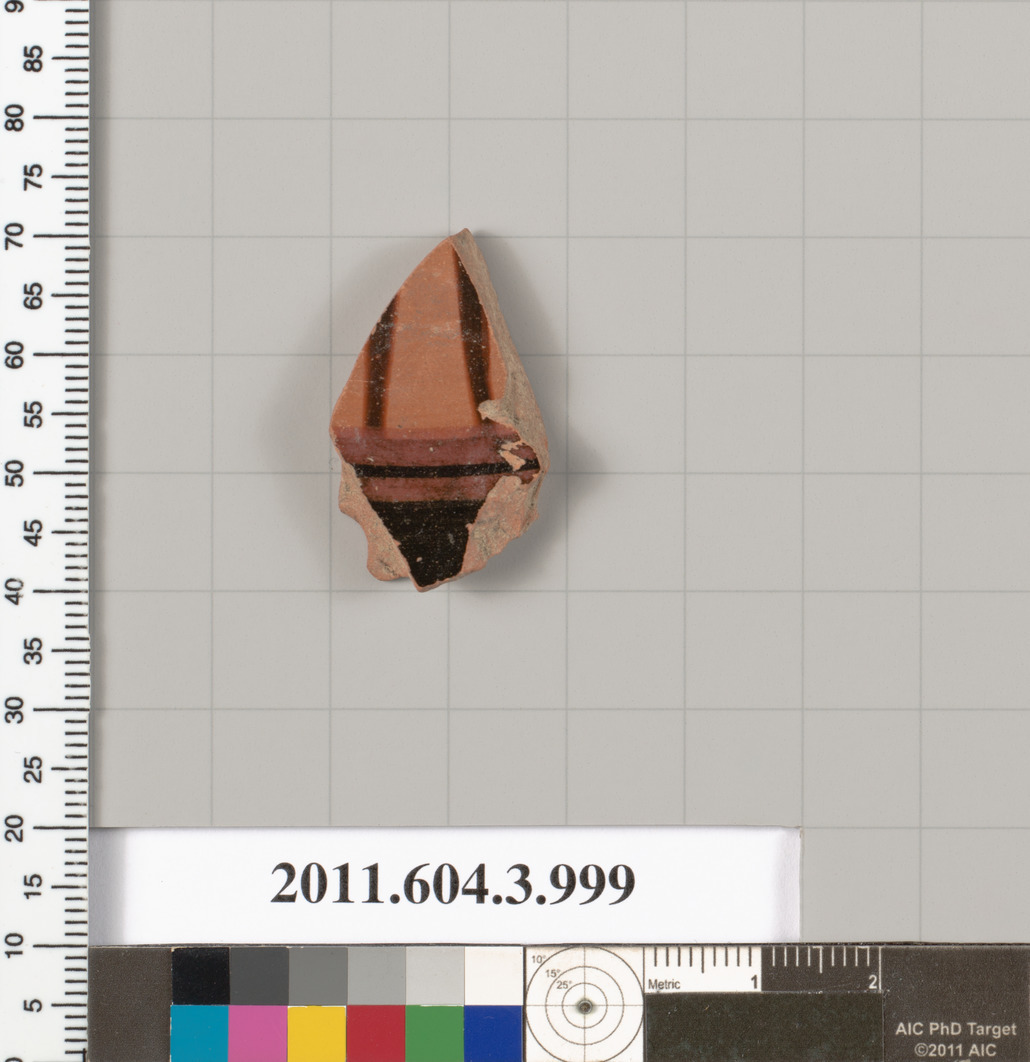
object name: lekanis lid fragment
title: Terracotta fragment of a lekanis lid (covered dish)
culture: greek, attic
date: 600-501 BCE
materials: terracotta